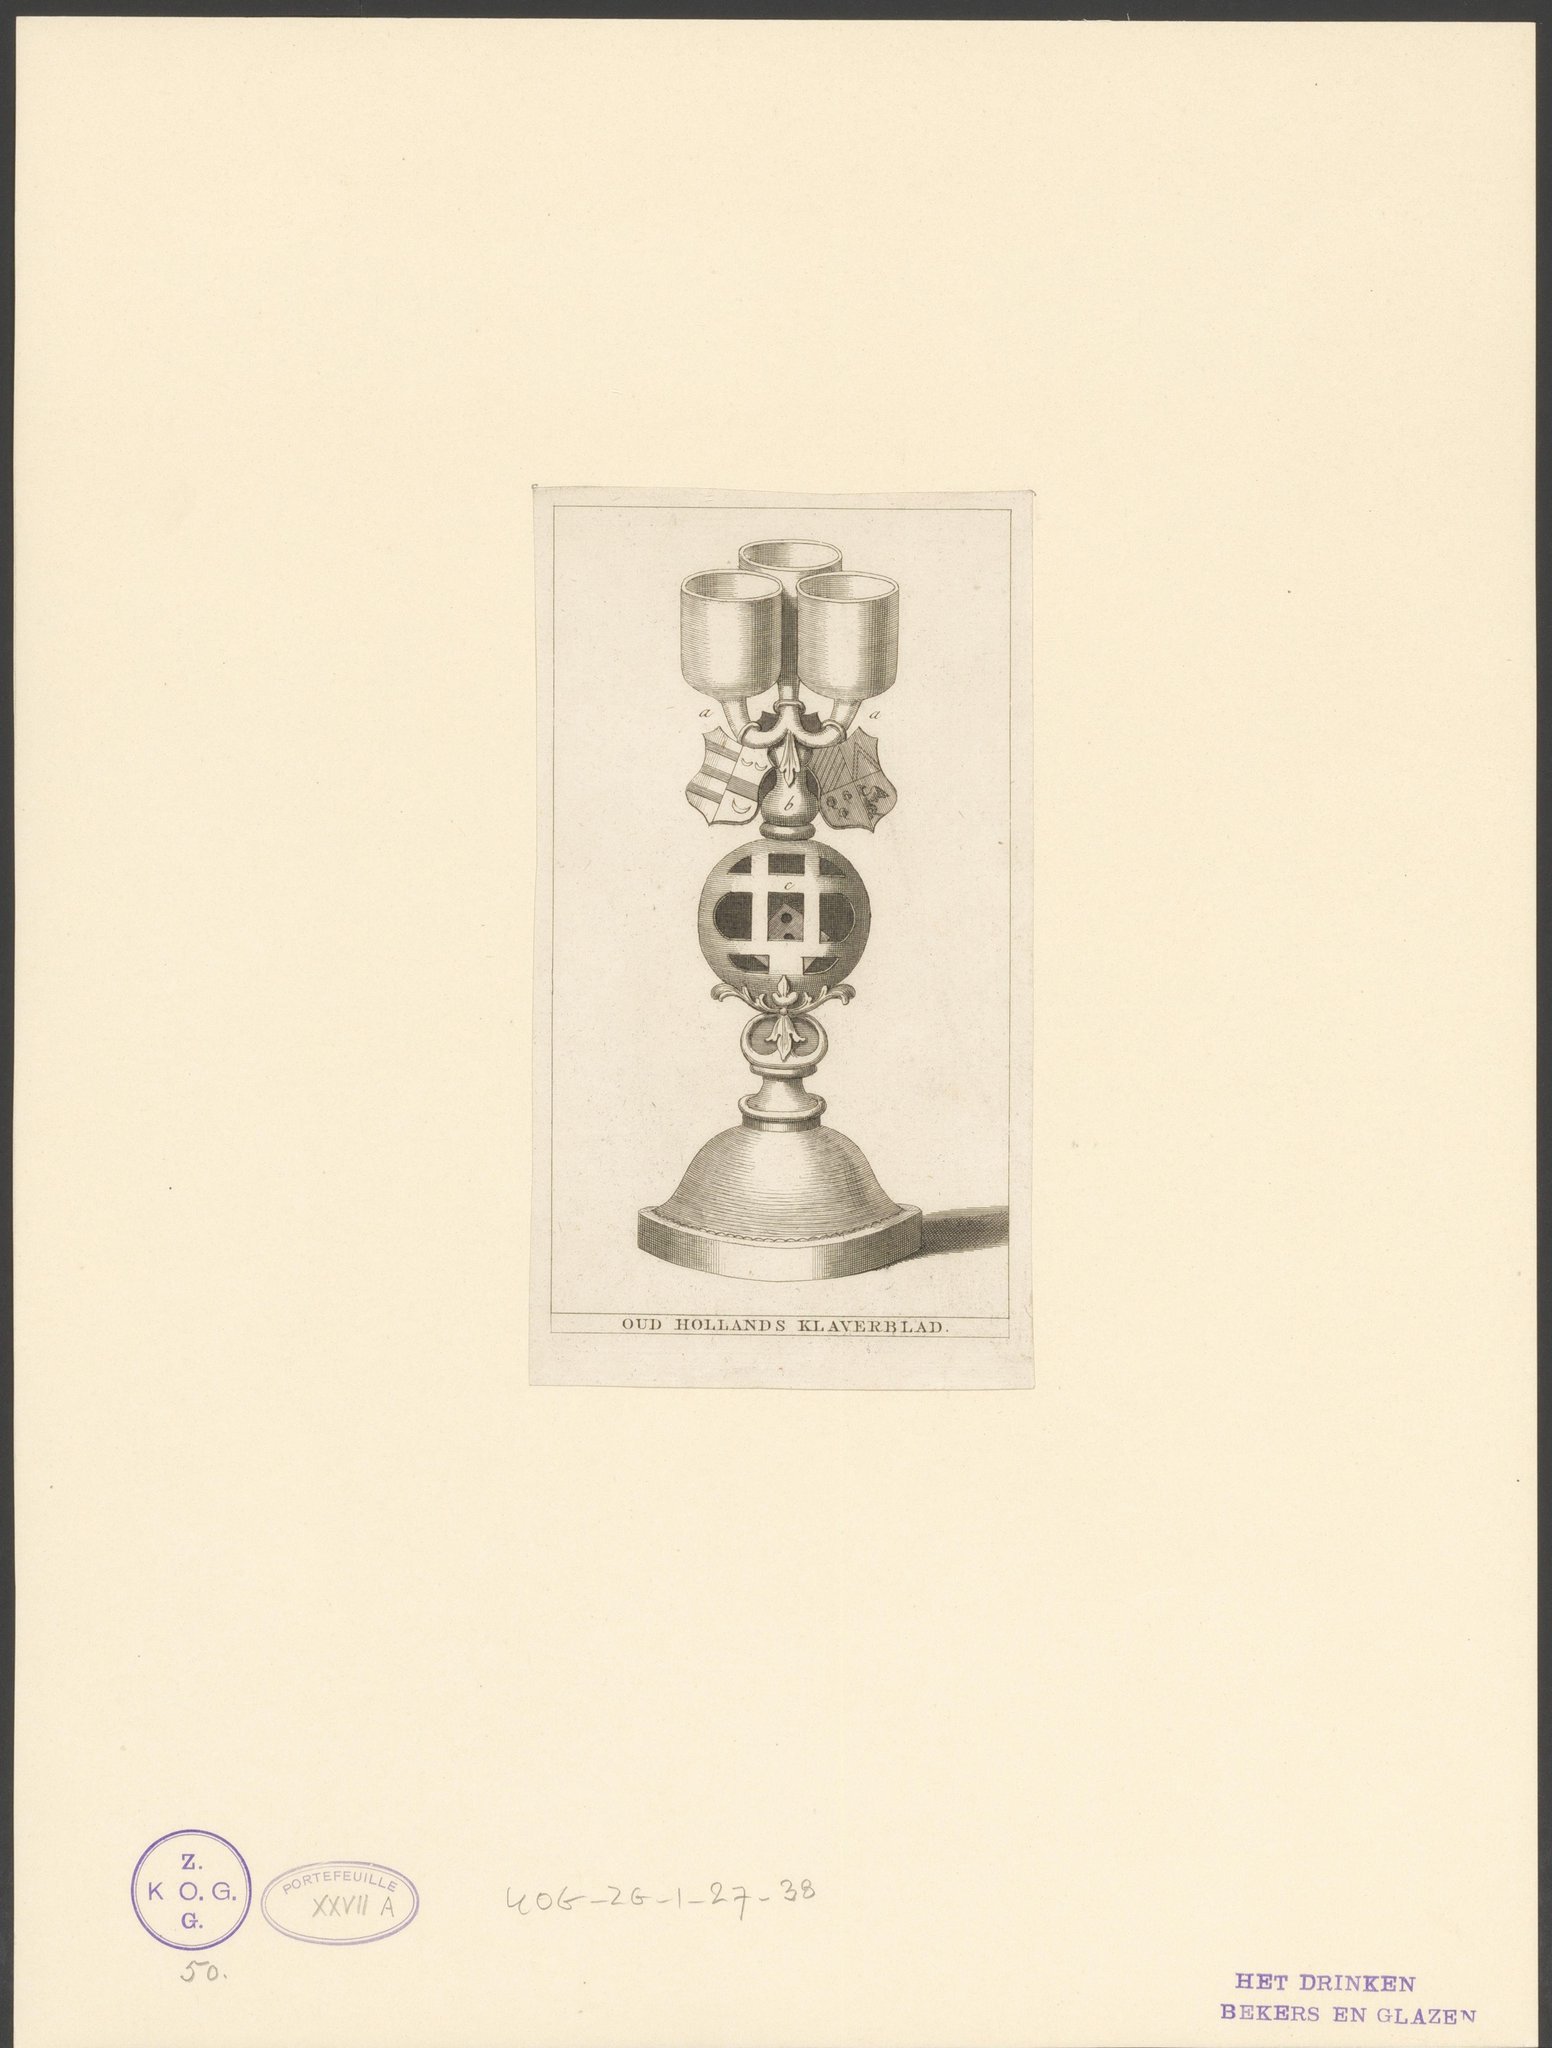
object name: print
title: Oud Hollands klaverblad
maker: Anonymous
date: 1808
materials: paper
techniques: etching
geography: netherlands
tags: drinking-vessels, alcoholic drinks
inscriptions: collector's mark: Lugt 1641, collector's mark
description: Gebruikt als illustratie in: J. Le Francq van Berkhey, Oud Hollands Vriendschap, tot Leydens Troost bij haren Ramp in den Jare 1807, Leiden: J. van Thoir, 1808, p. 188/189.